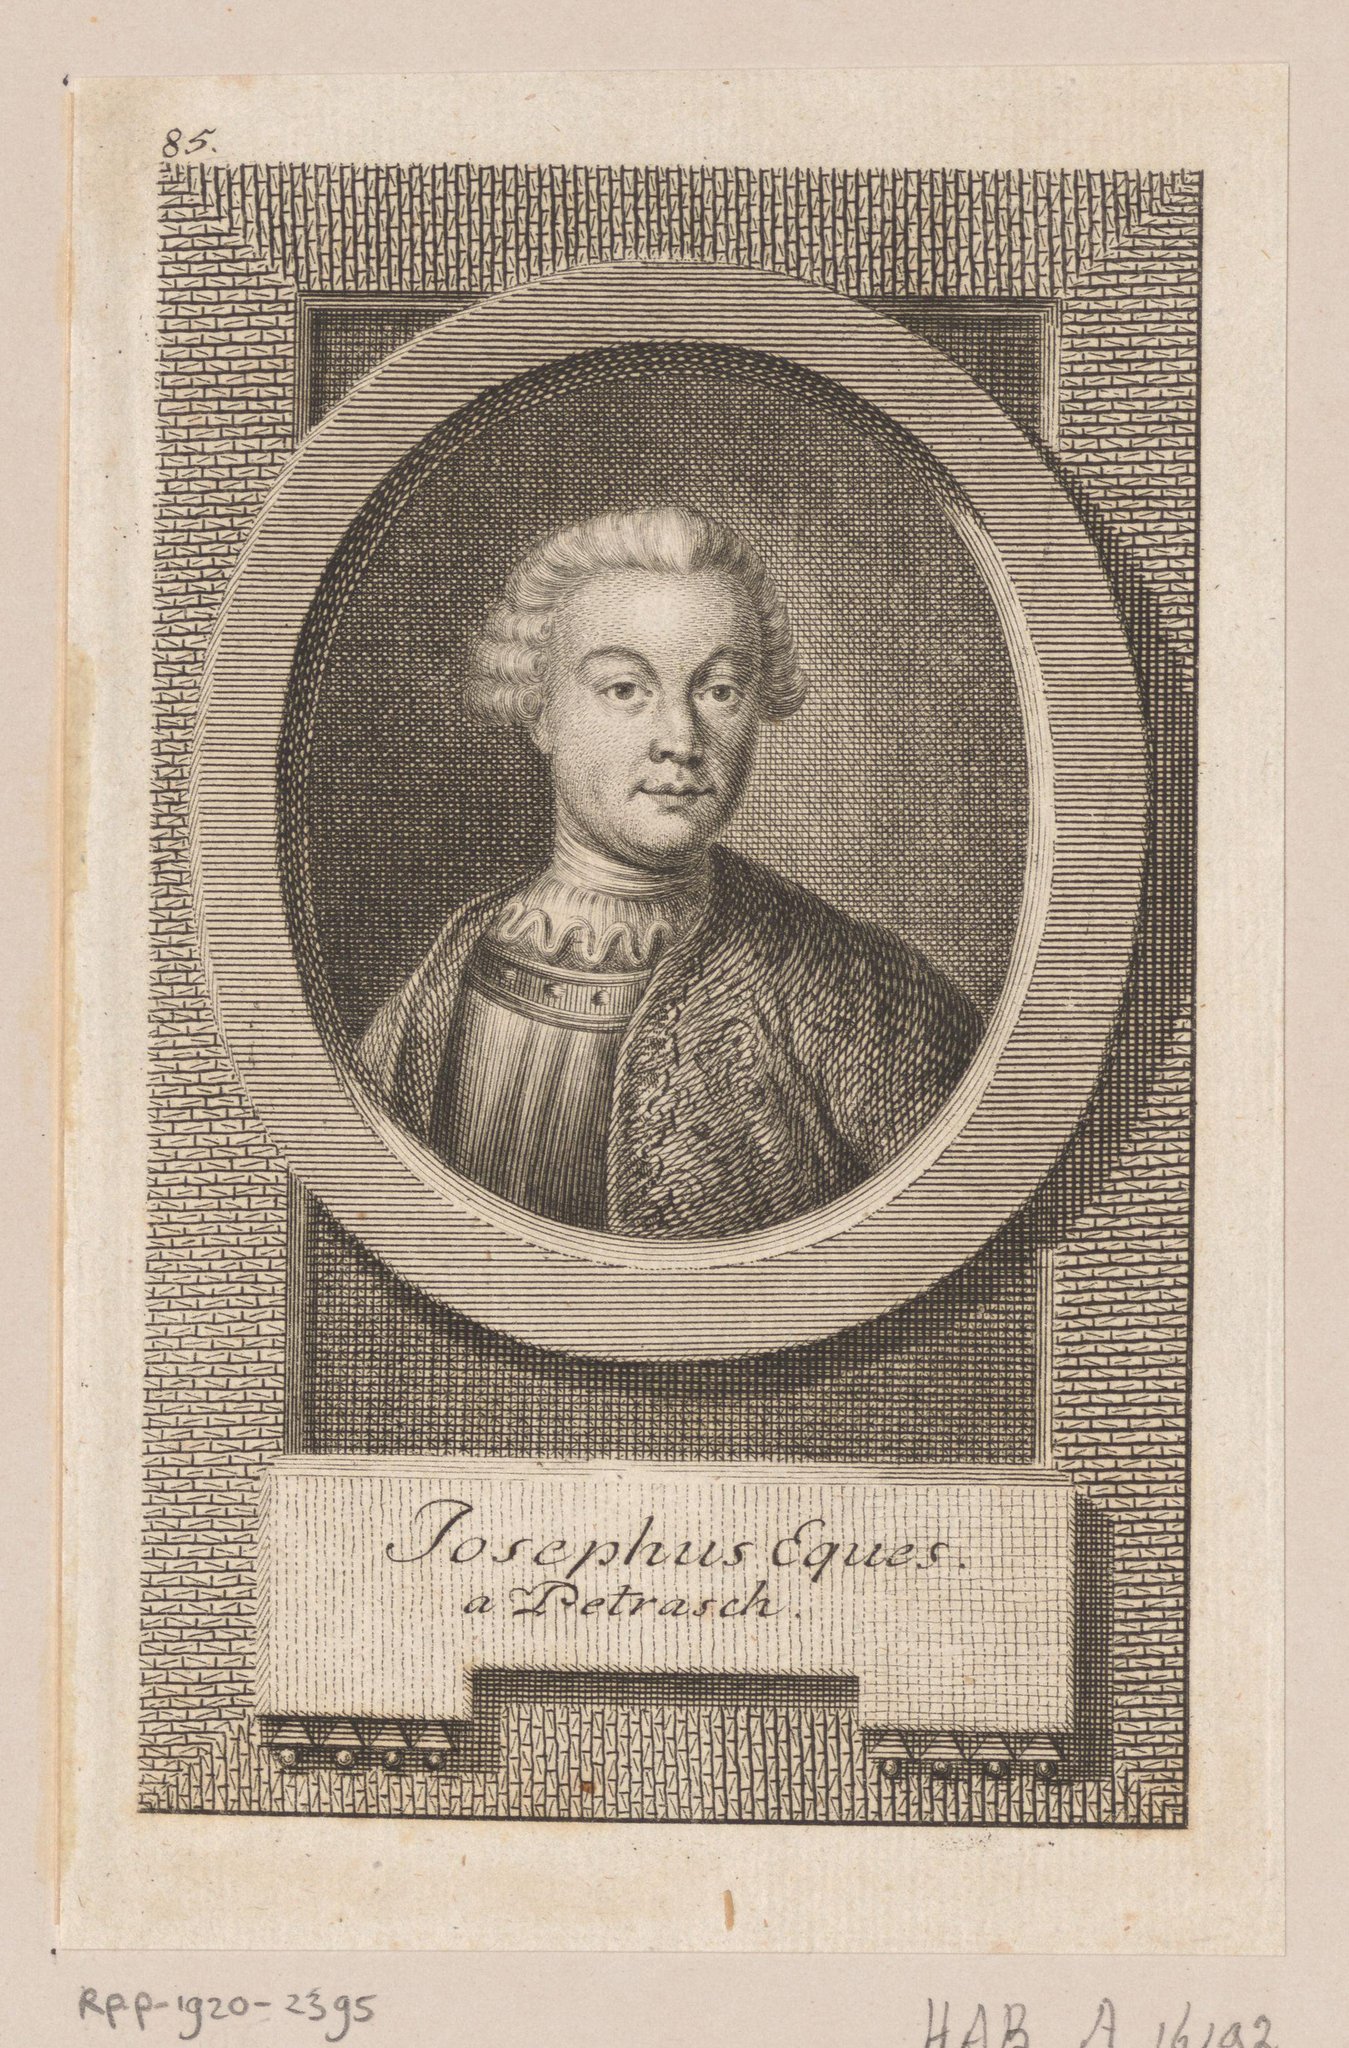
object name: book illustration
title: Portret van Joseph Leopold von Petrasch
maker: jan balzer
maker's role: print maker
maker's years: 1736-1799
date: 1772-1775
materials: paper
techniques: engraving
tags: adult man, historical persons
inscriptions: collector's mark: Lugt 2228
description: Prent mogelijk uit: Balzer, Jan. 87 Abbildungen Böhmischer und Mährischer Gelehrten und Künstler (...). Praag: s.n., 1772. Prent ook gebruikt in latere edities (1774 en 1780). Of mogelijk uit: Effigies Virorum eruditorum atque Artificum Bohemiae et Moraviae (...). Praag: s.n., 1773-1775.